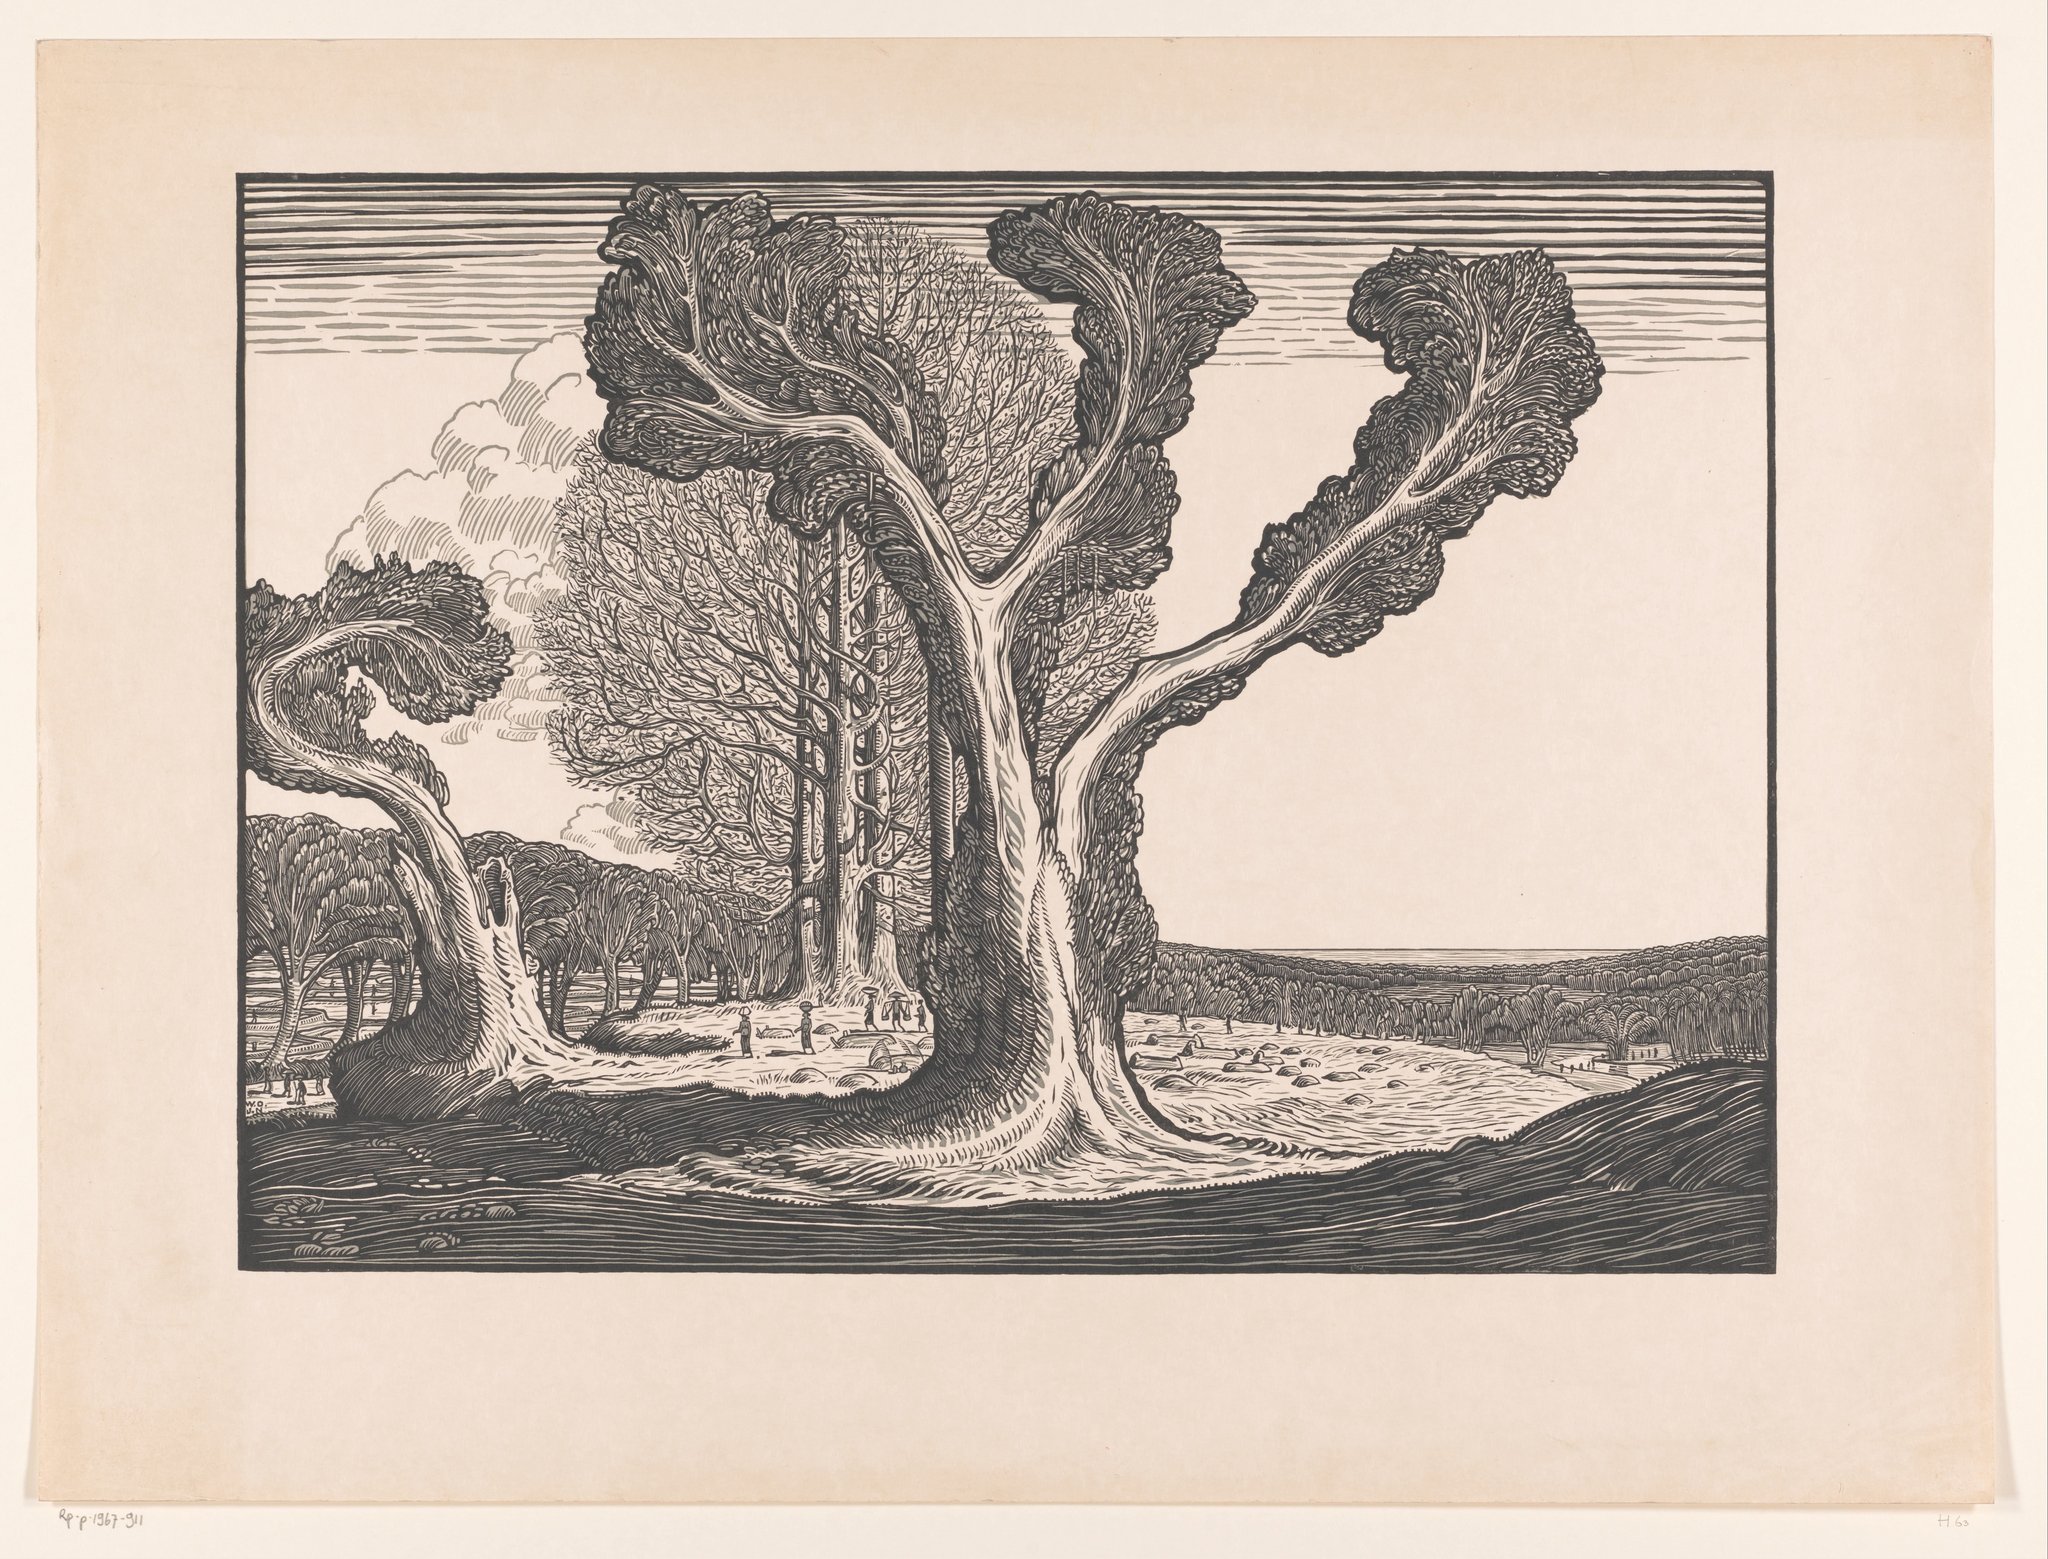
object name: print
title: Landschap op Bali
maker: wijnand otto jan nieuwenkamp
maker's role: draughtsman, print maker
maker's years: 1874-1950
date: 1908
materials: paper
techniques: woodcut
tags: trees, jungle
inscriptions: collector's mark: Lugt 2228, collector's mark: Lugt 2760